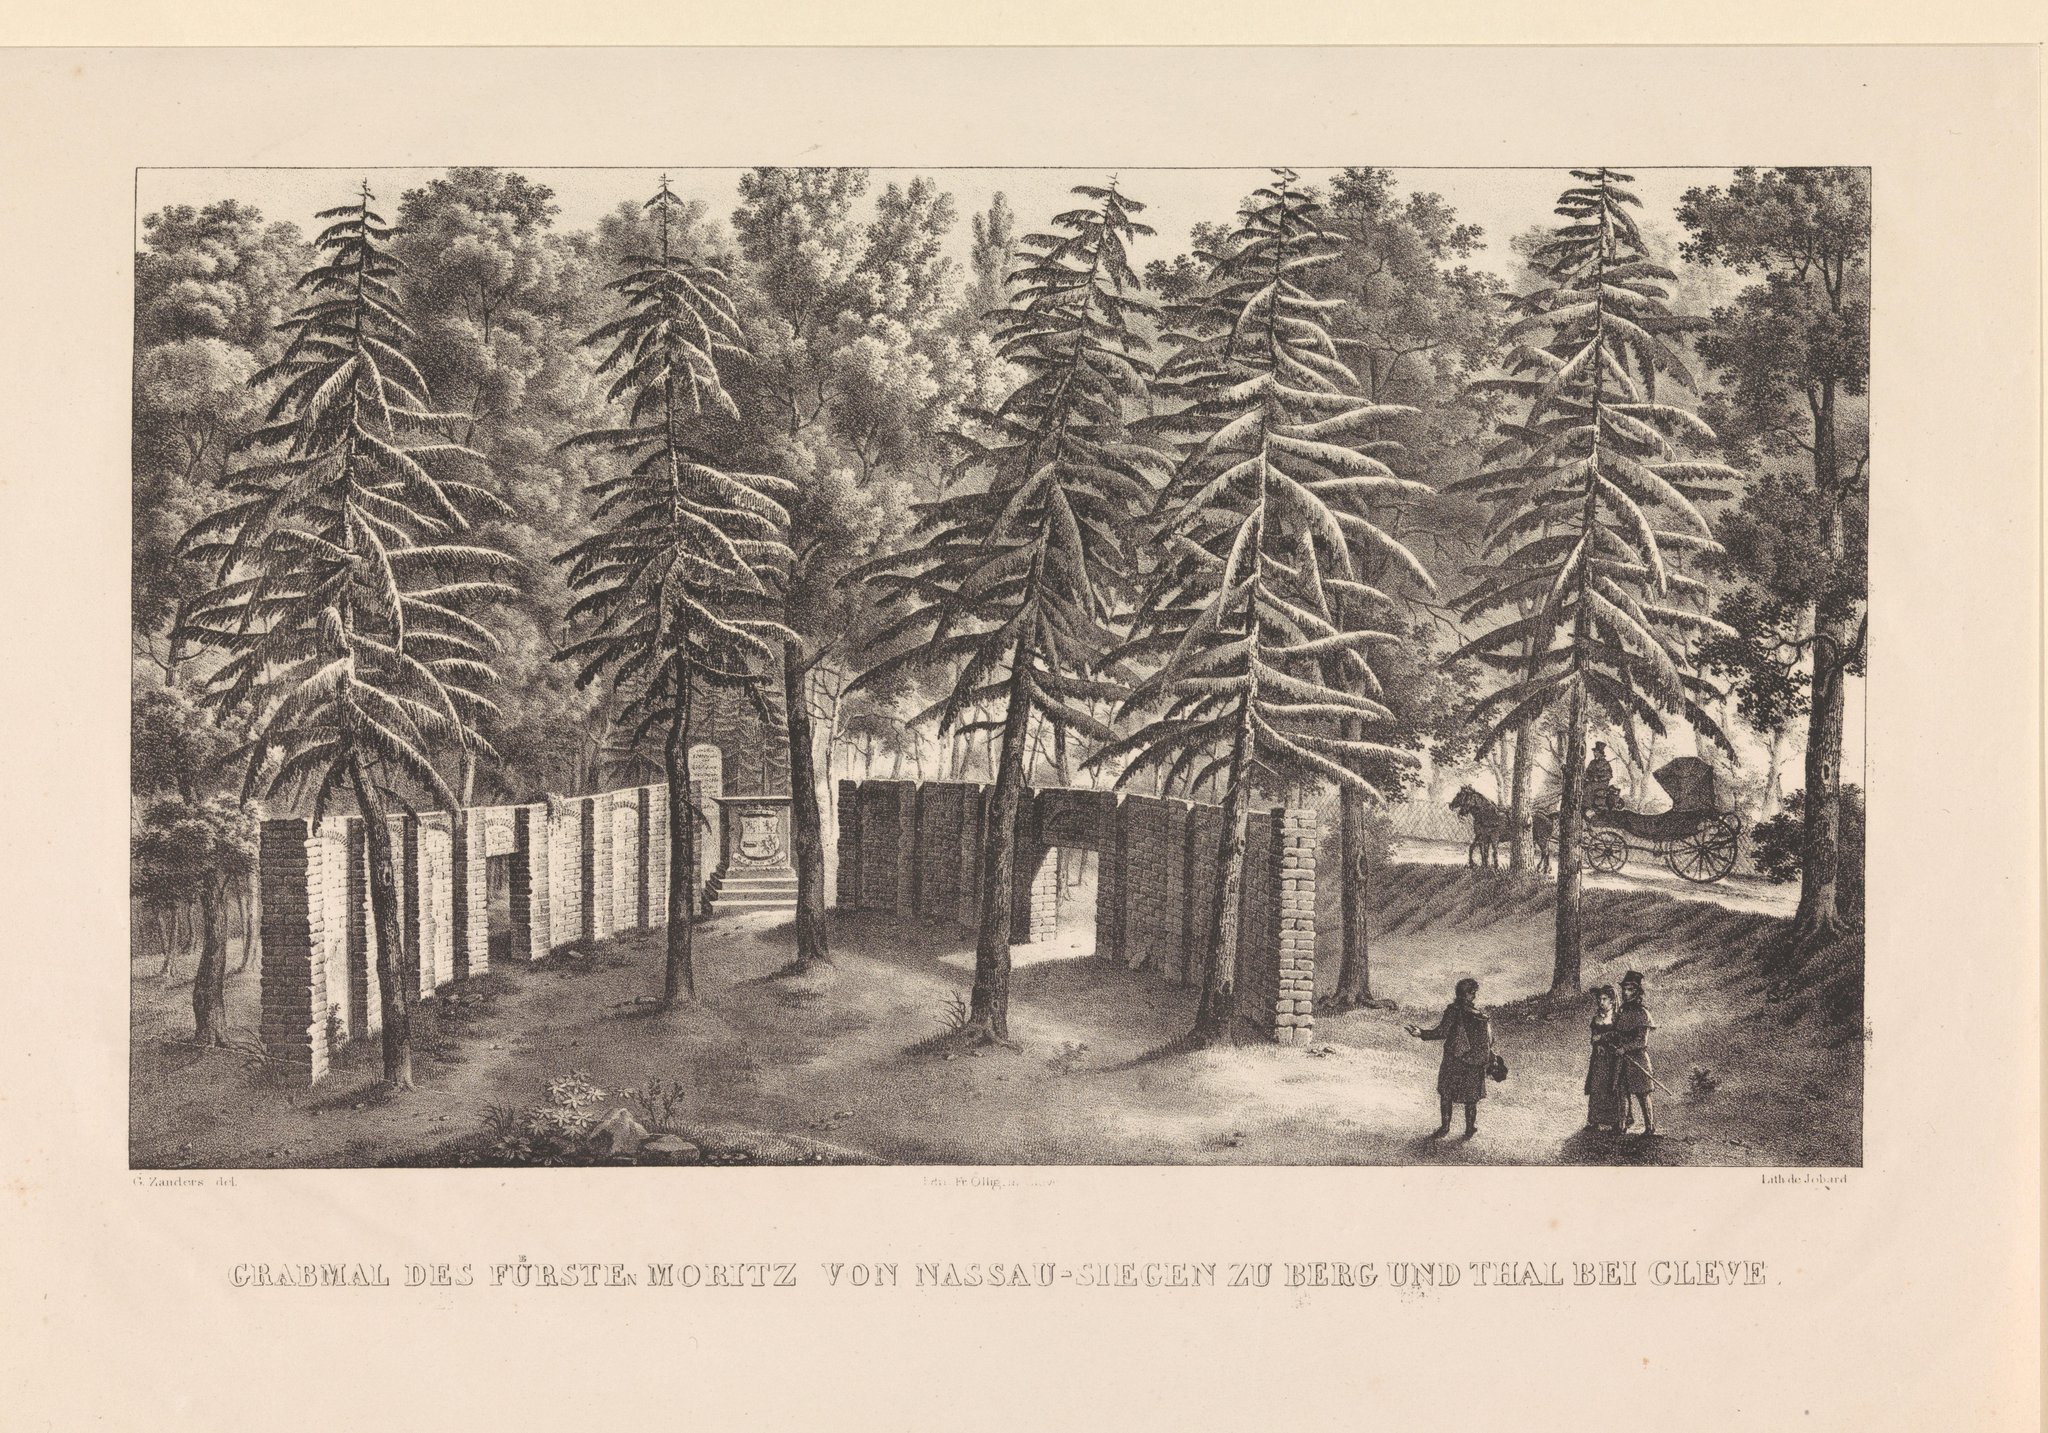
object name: print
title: Grafmonument voor Johan Maurits, graaf van Nassau-Siegen, 1678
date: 1825-1832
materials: paper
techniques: lithograph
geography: cleves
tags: earl, johan maurits graaf van nassau-siegen, grave-building, monumental tomb, cleves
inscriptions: collector's mark: Lugt 2228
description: Grafmonument voor Johan Maurits te Kleef, overleden op 20 december 1679, voltooid in 1678. Er omheen staat een aantal figuren. In de ondermarge een regel Duitse tekst.